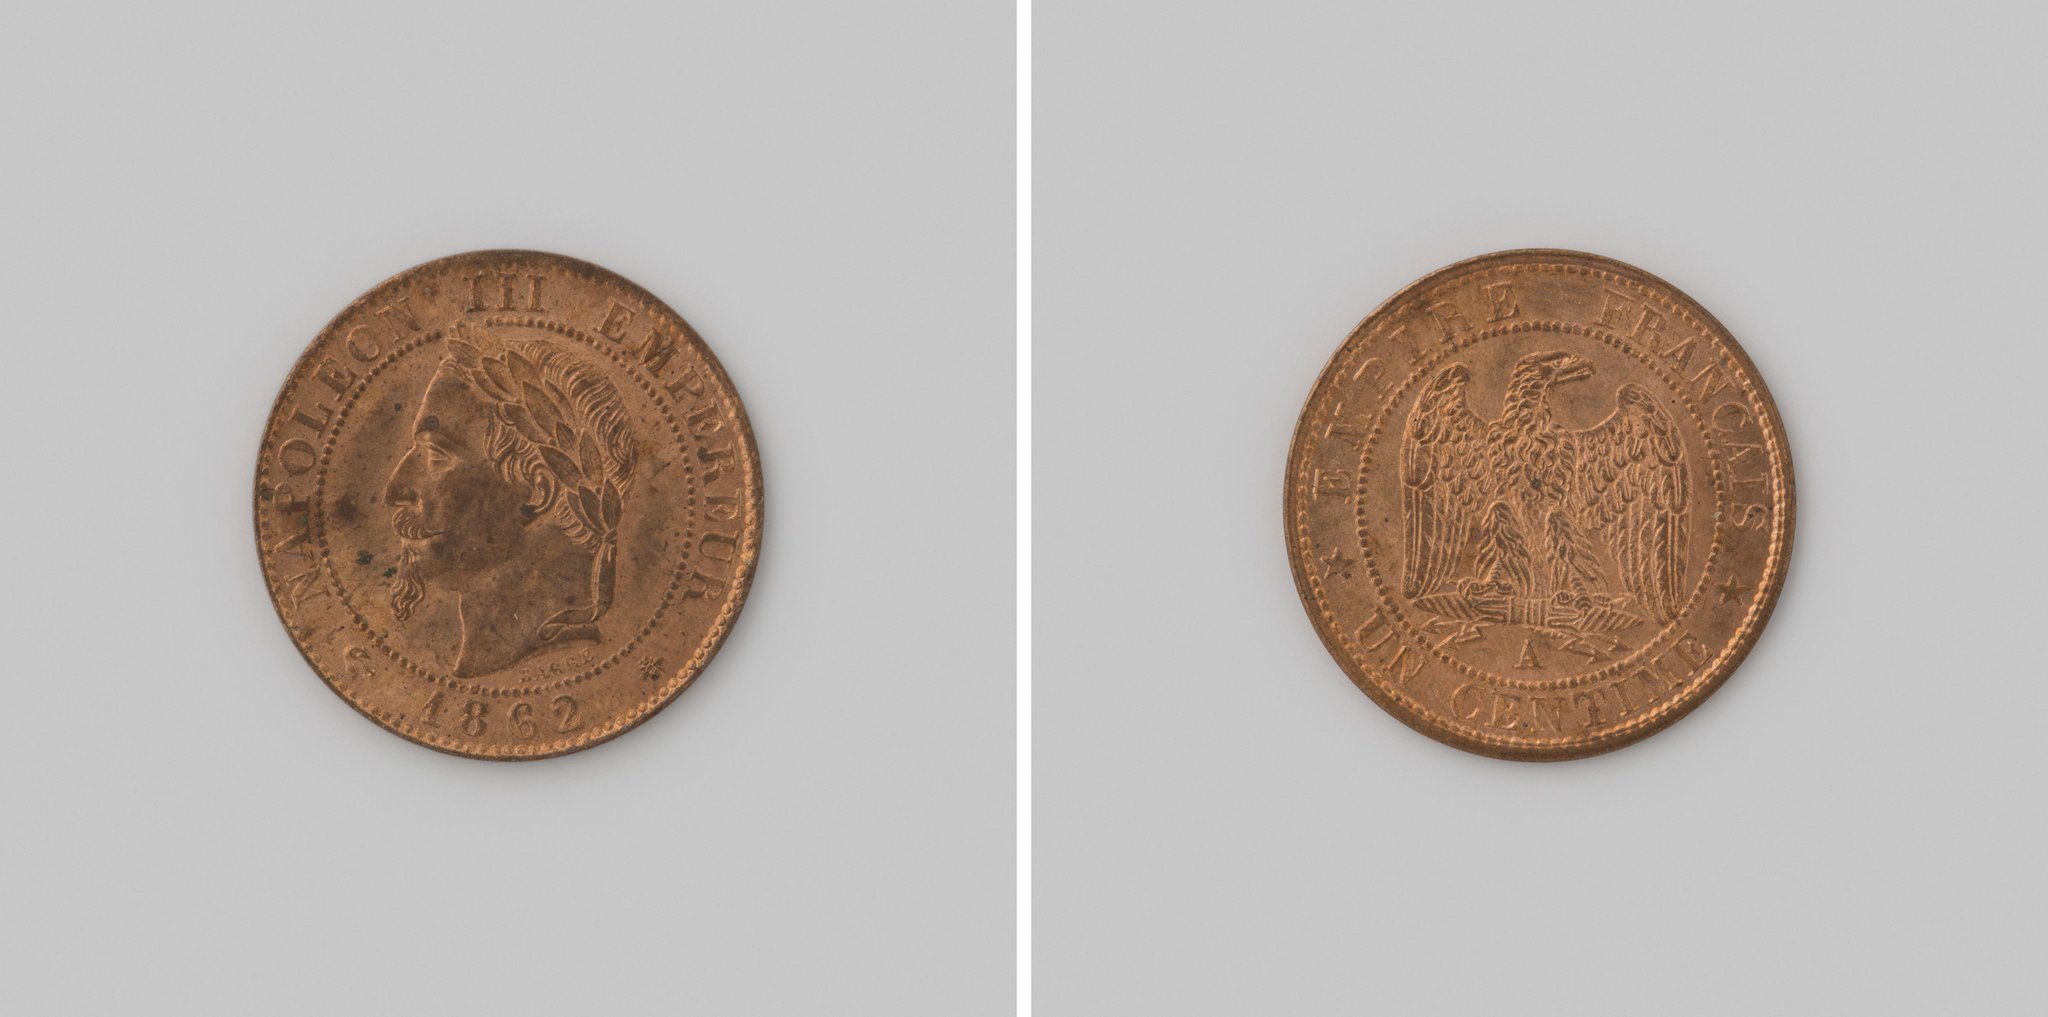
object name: centime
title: Keizerrijk Frankrijk, Napoleon III, centime,1862 A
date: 1862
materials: bronze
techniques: striking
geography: paris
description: Bronzen munt. Voorzijde: gelauwerd hoofd van de keizer naar links. Jaartal onderaan. Keerzijde: op bundel, waaruit bliksemschichten, staande, naar rechts kijkende adelaar met gespreide vleugels, waaronder de letter A [=Parijs]. Waarde-aanduiding onderaan in omschrift. Gladde rand.